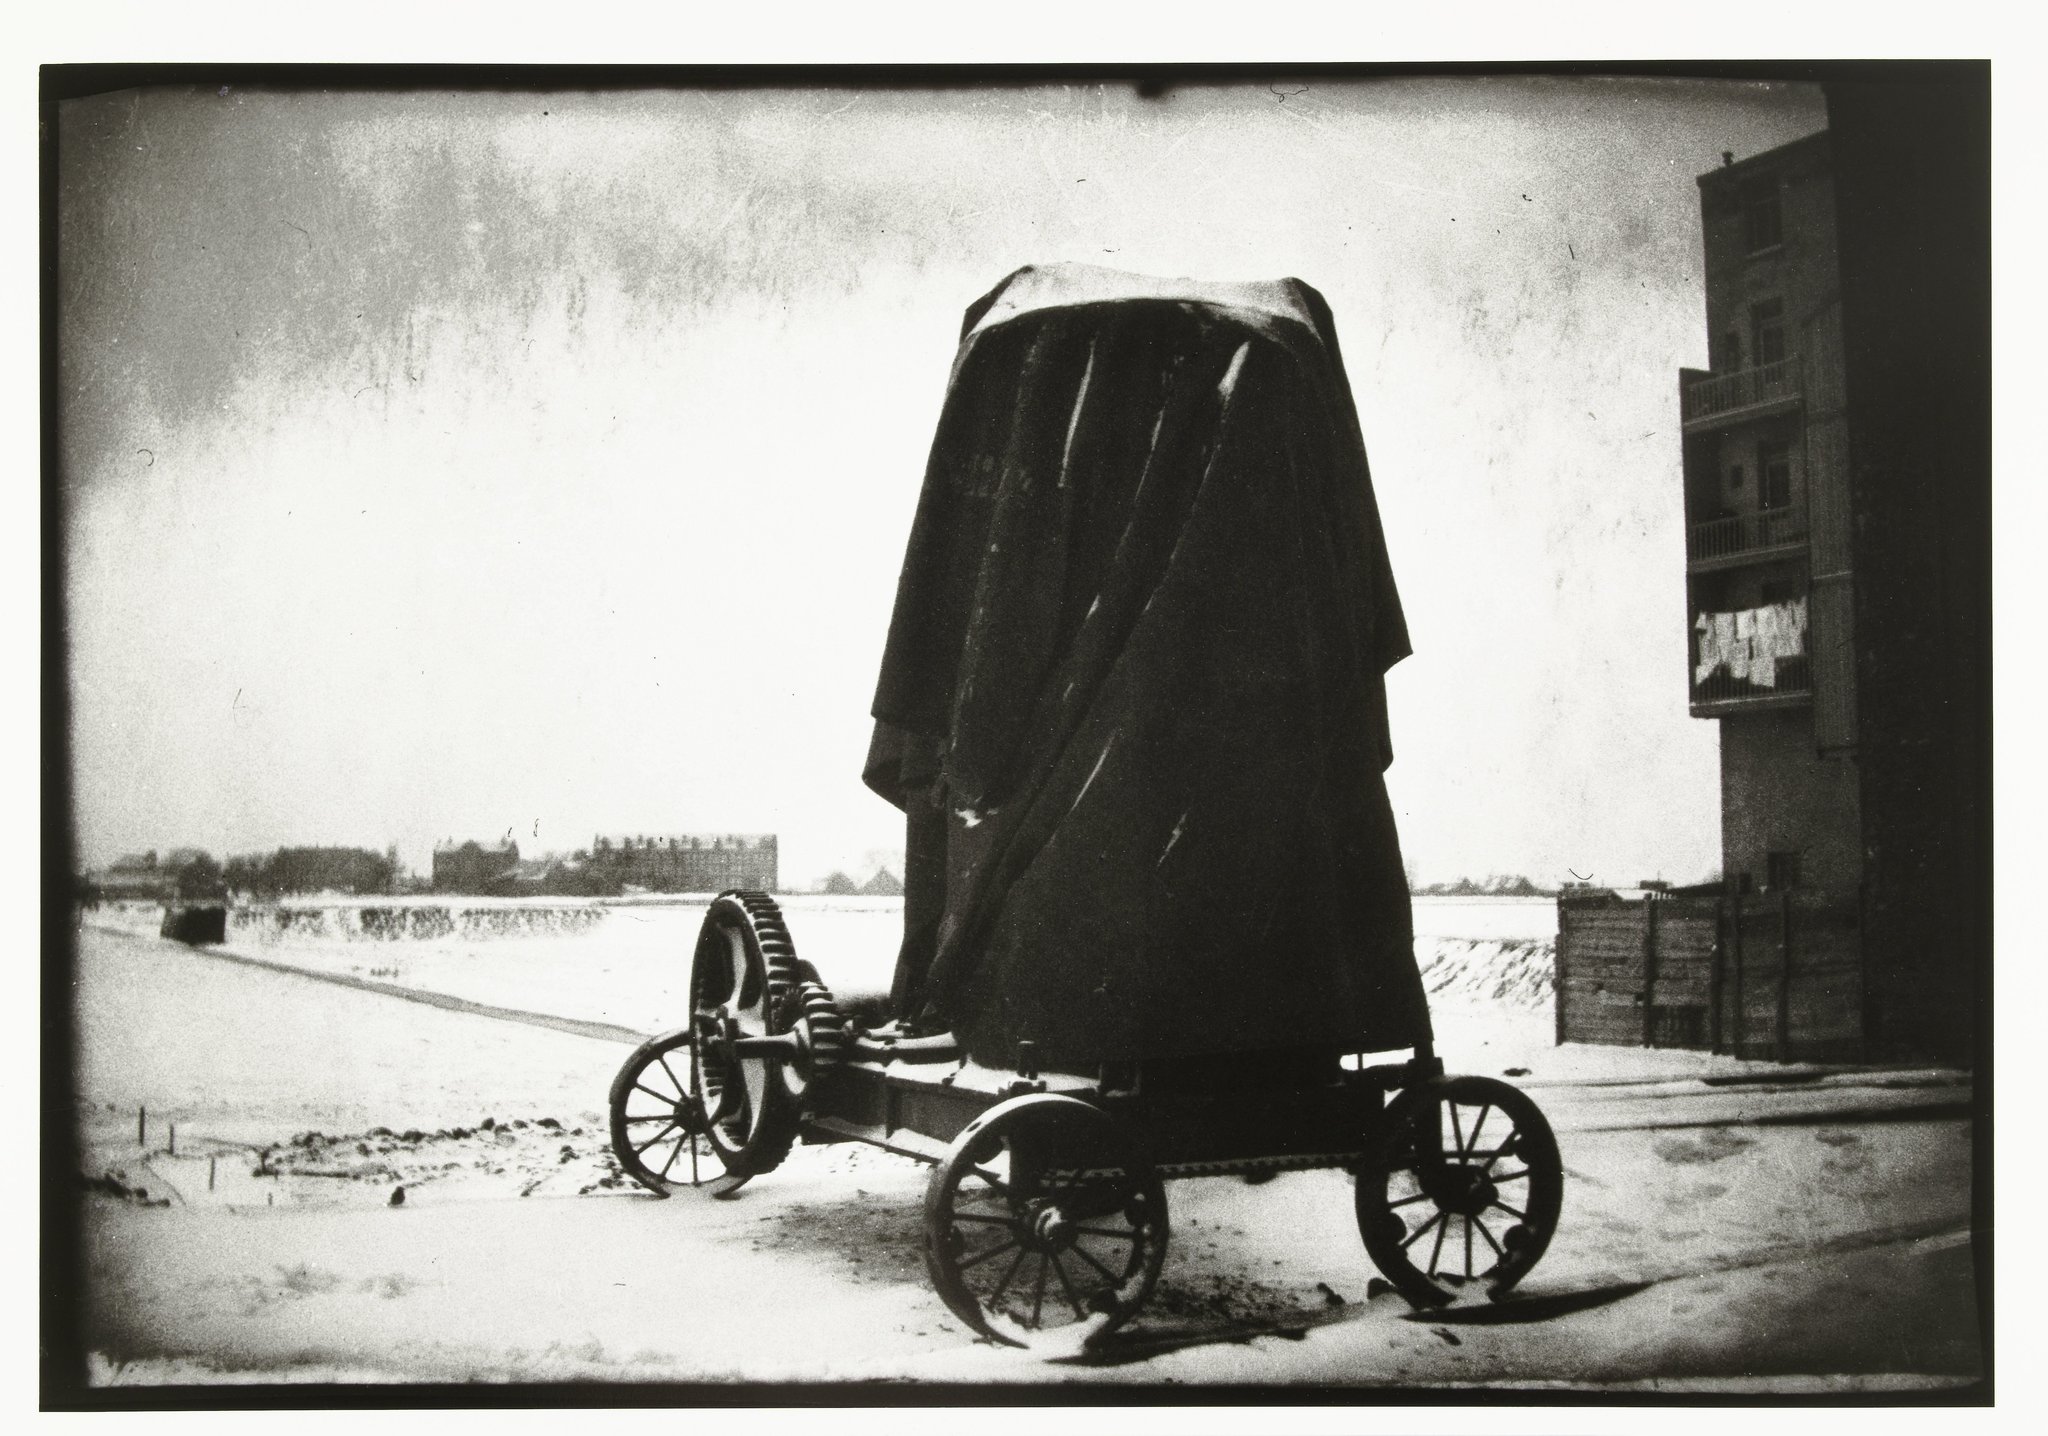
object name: photograph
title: Cementmolen in een winterlandschap bij de Overtoom in Amsterdam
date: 1890-1910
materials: paper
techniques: gelatin silver print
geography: amsterdam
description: Moderne afdruk van negatief BR 1042 (collectie RKD).